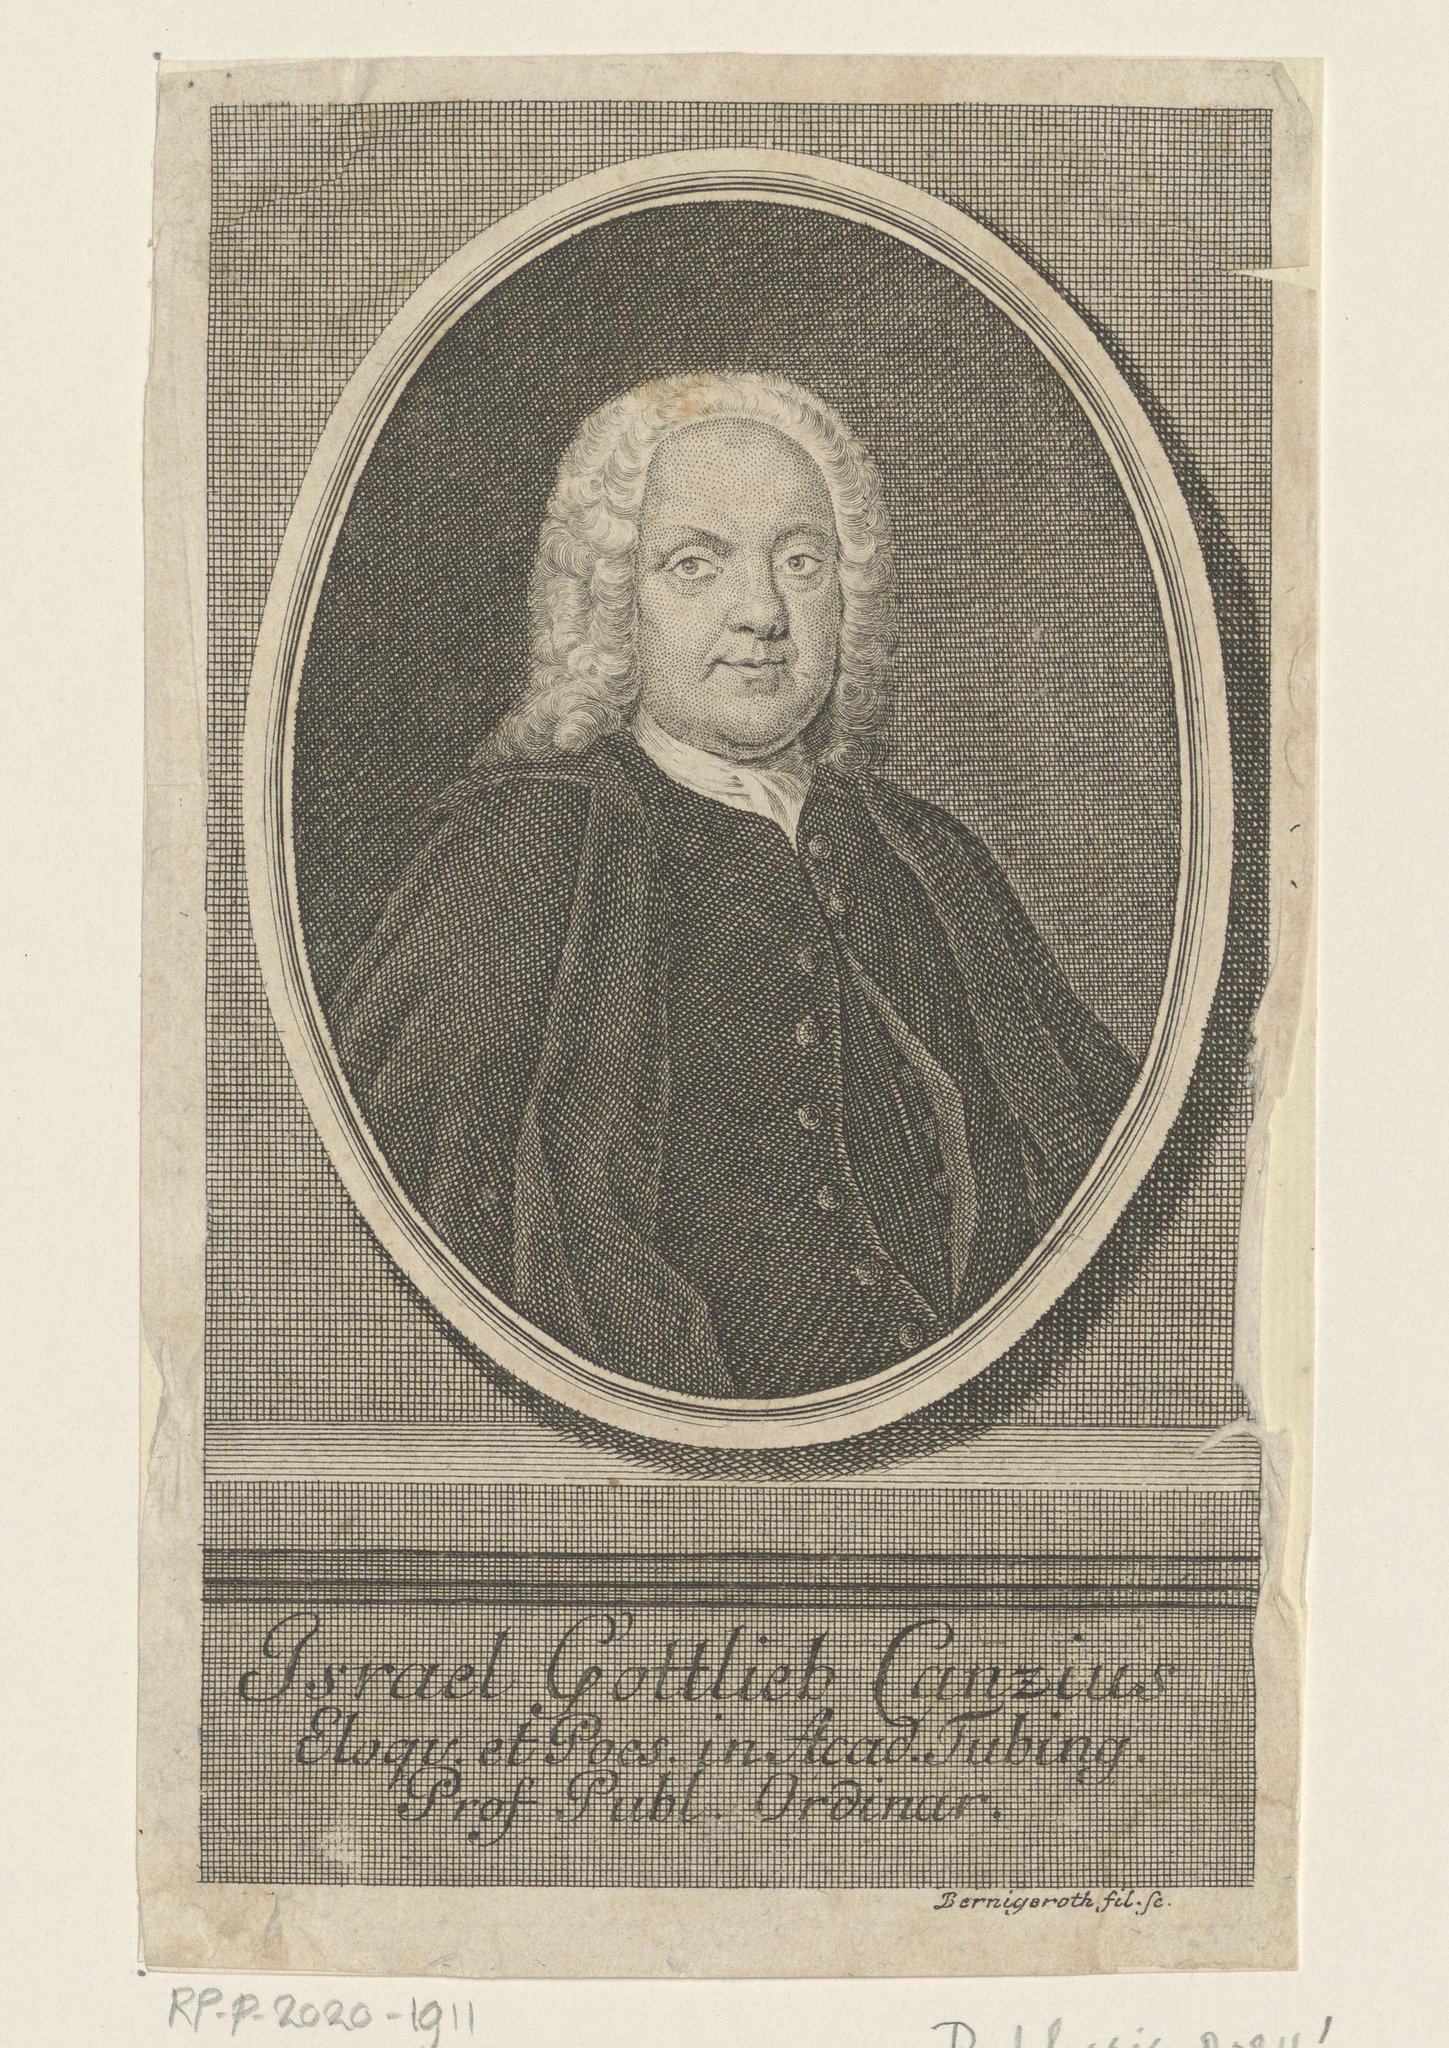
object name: print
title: Portret van Israel Gottlieb Canz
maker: johann friedrich gleditsch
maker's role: publisher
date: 1739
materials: paper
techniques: engraving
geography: leipzig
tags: historical persons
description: Prent waarschijnlijk uit: Deutsche acta eruditorum, nr. 231, 1739.